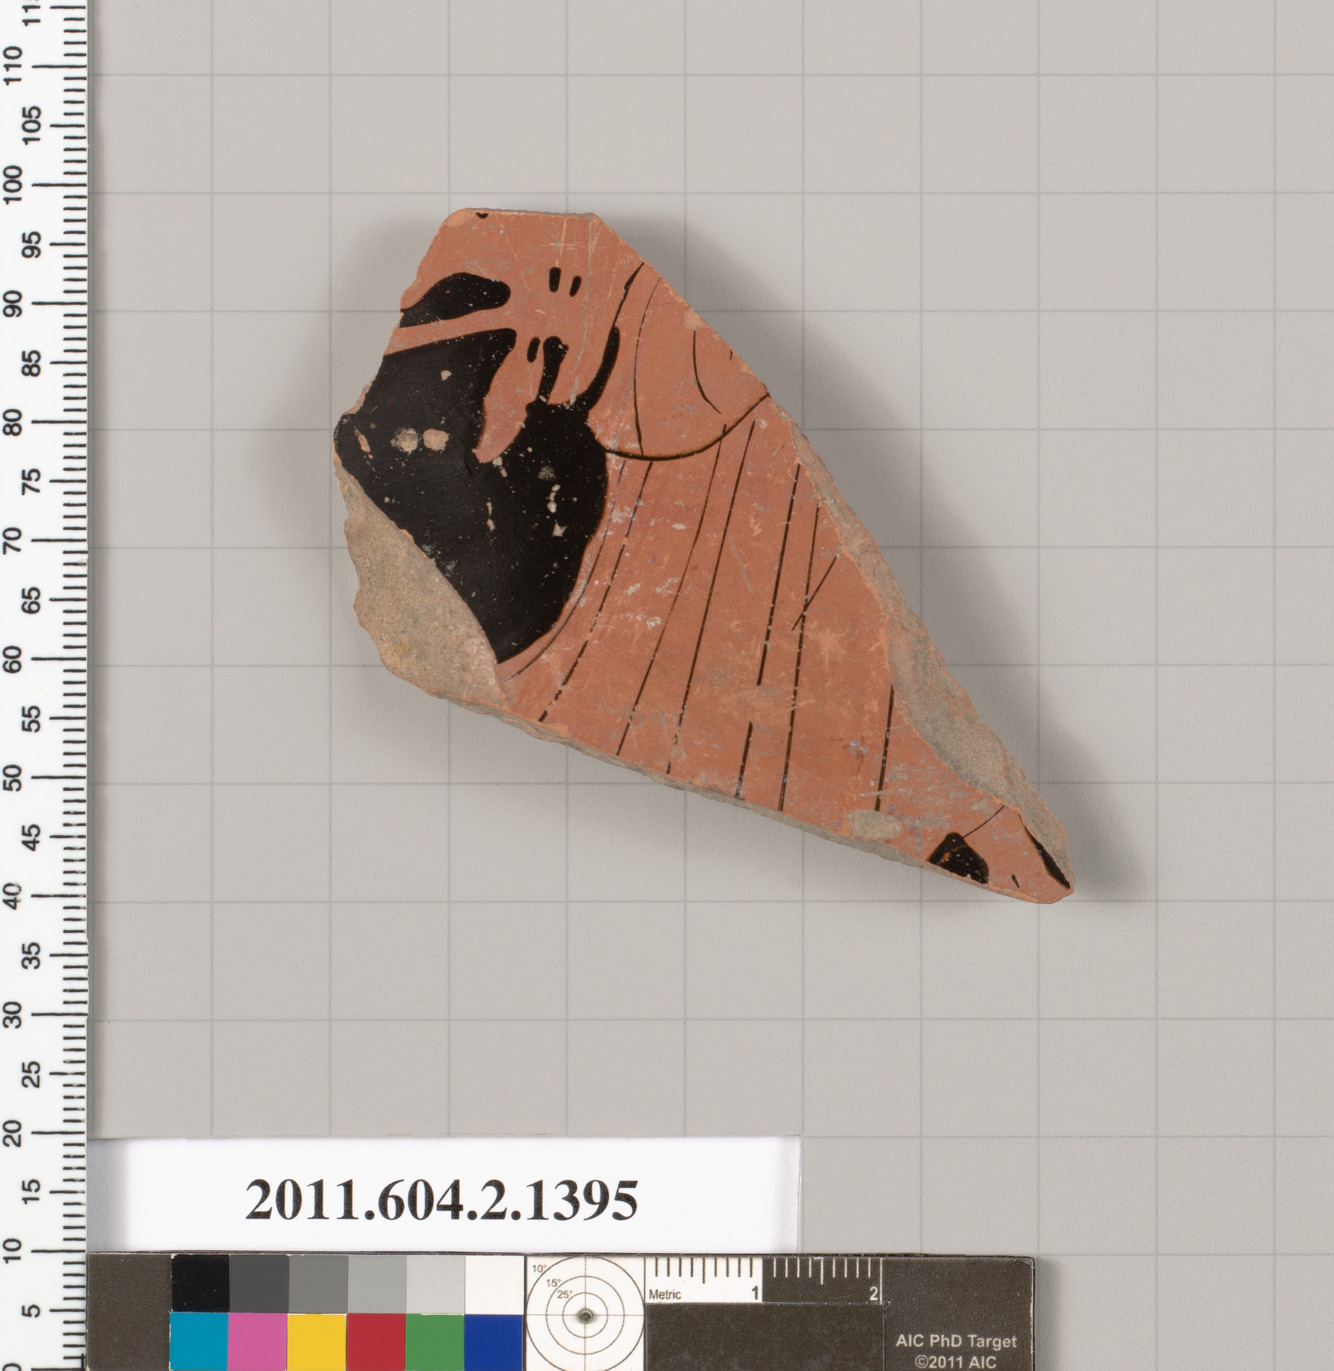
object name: skyphos fragment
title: Terracotta fragment of a skyphos (deep drinking cup)?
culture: greek, attic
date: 450-426 BCE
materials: terracotta